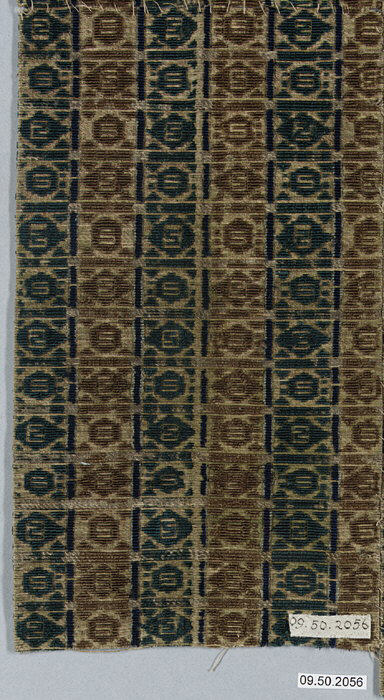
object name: textile fragment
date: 1801-1900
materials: linen, metal thread, silk, velvet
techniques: brocade, weave, voiding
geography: india